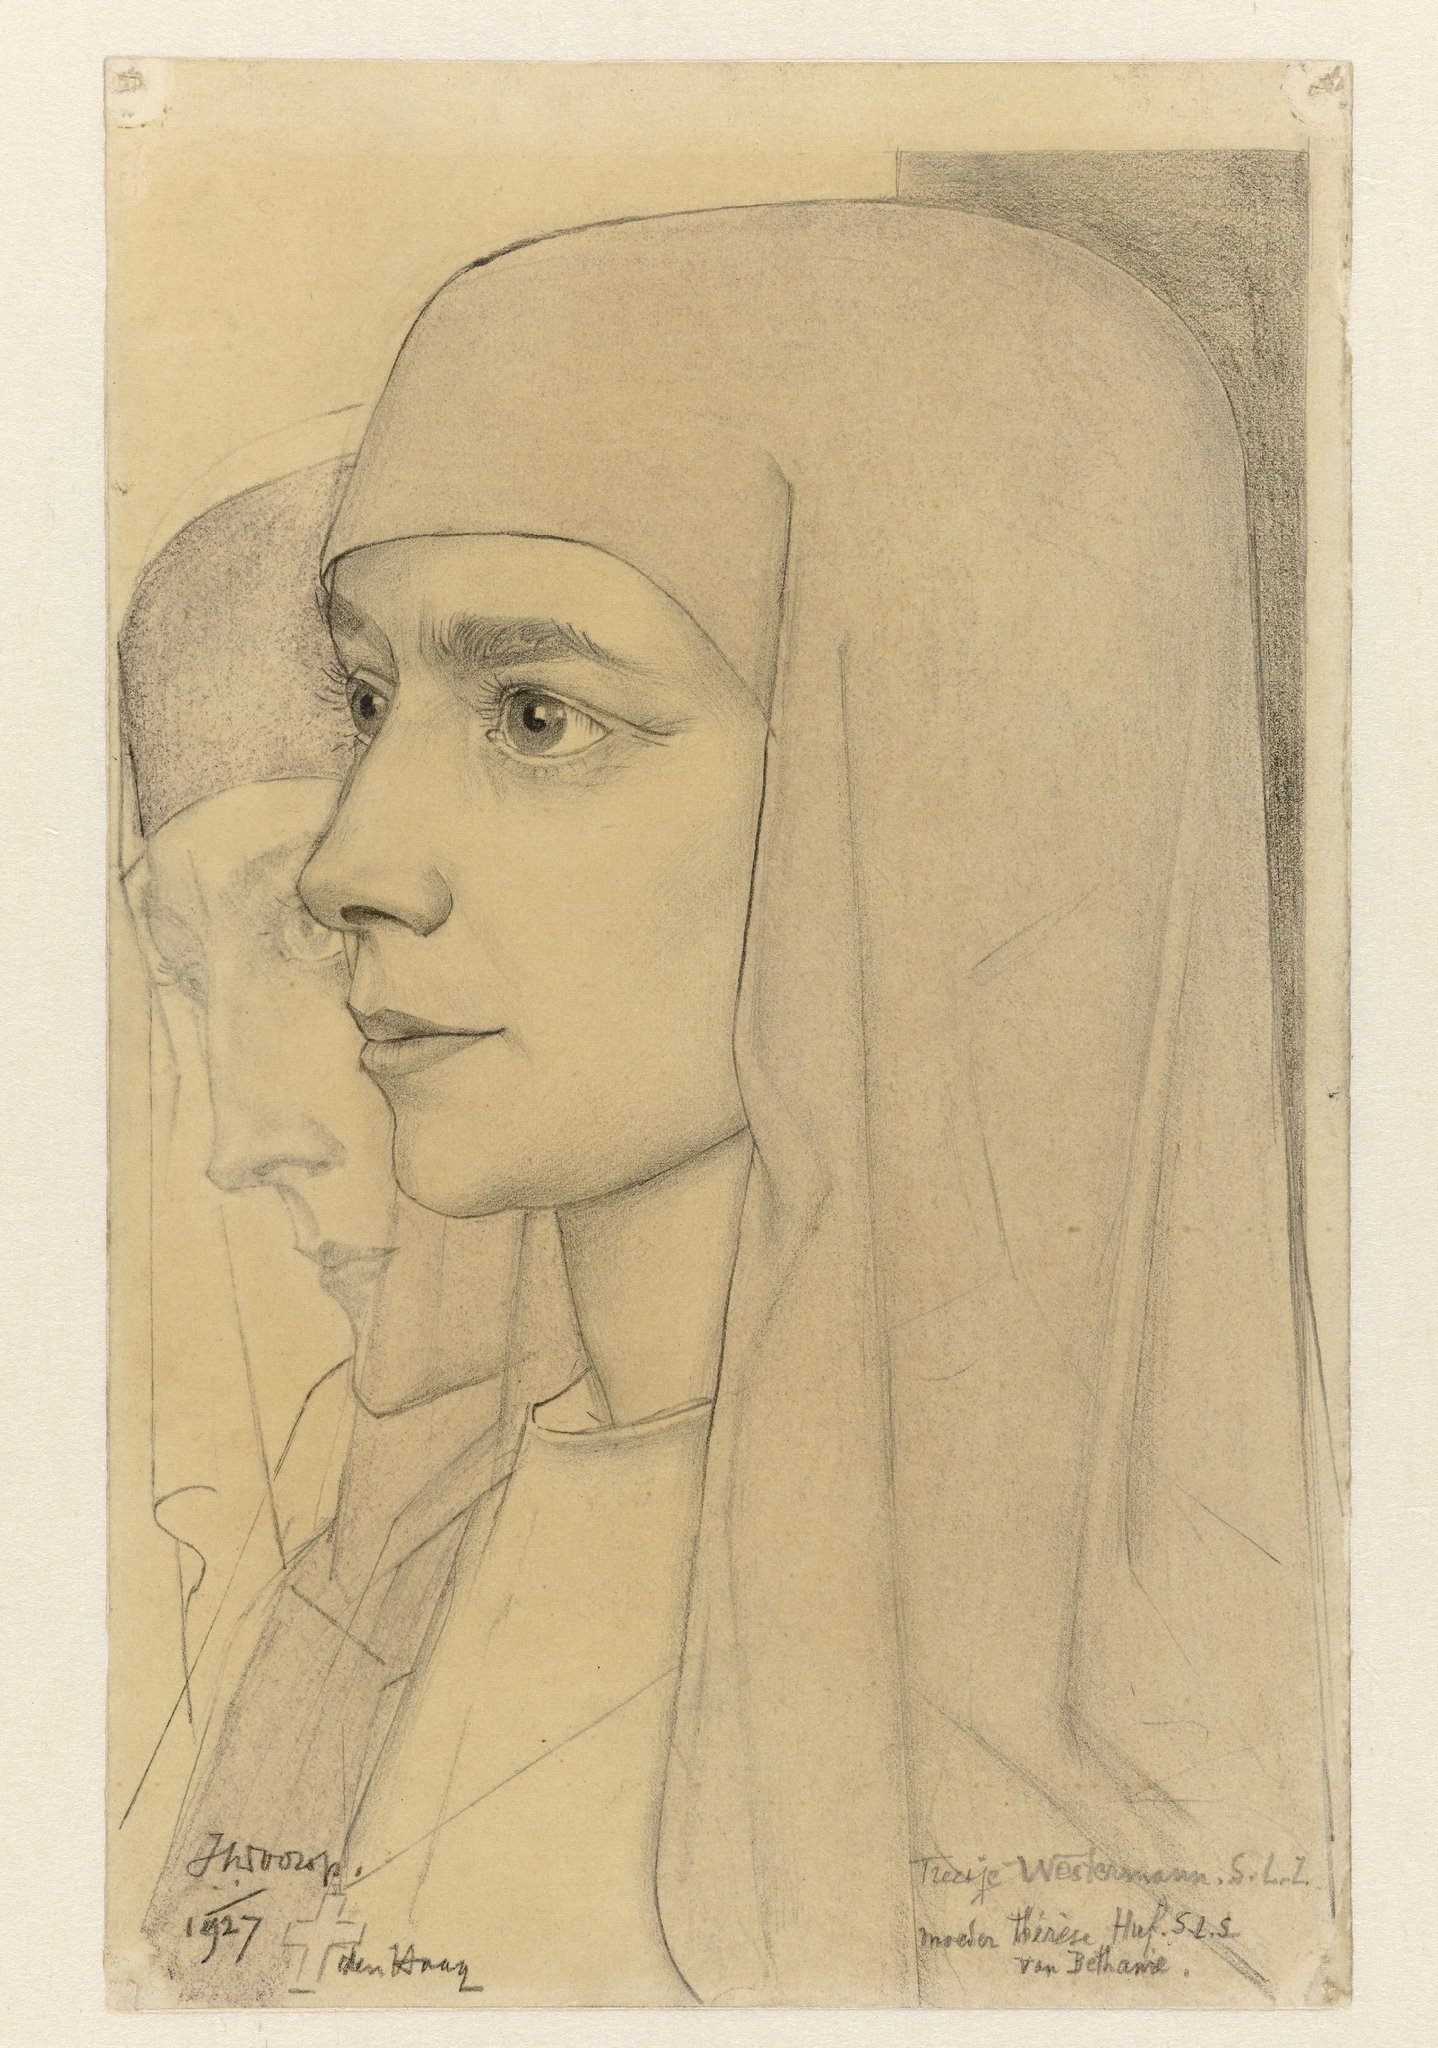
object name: drawing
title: Portret van Treesje Westermann, Moeder Thérèse Huf van Bethanië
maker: jan toorop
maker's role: draughtsman, painter, print maker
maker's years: 1858-1928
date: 1927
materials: paper, pencil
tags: historical persons